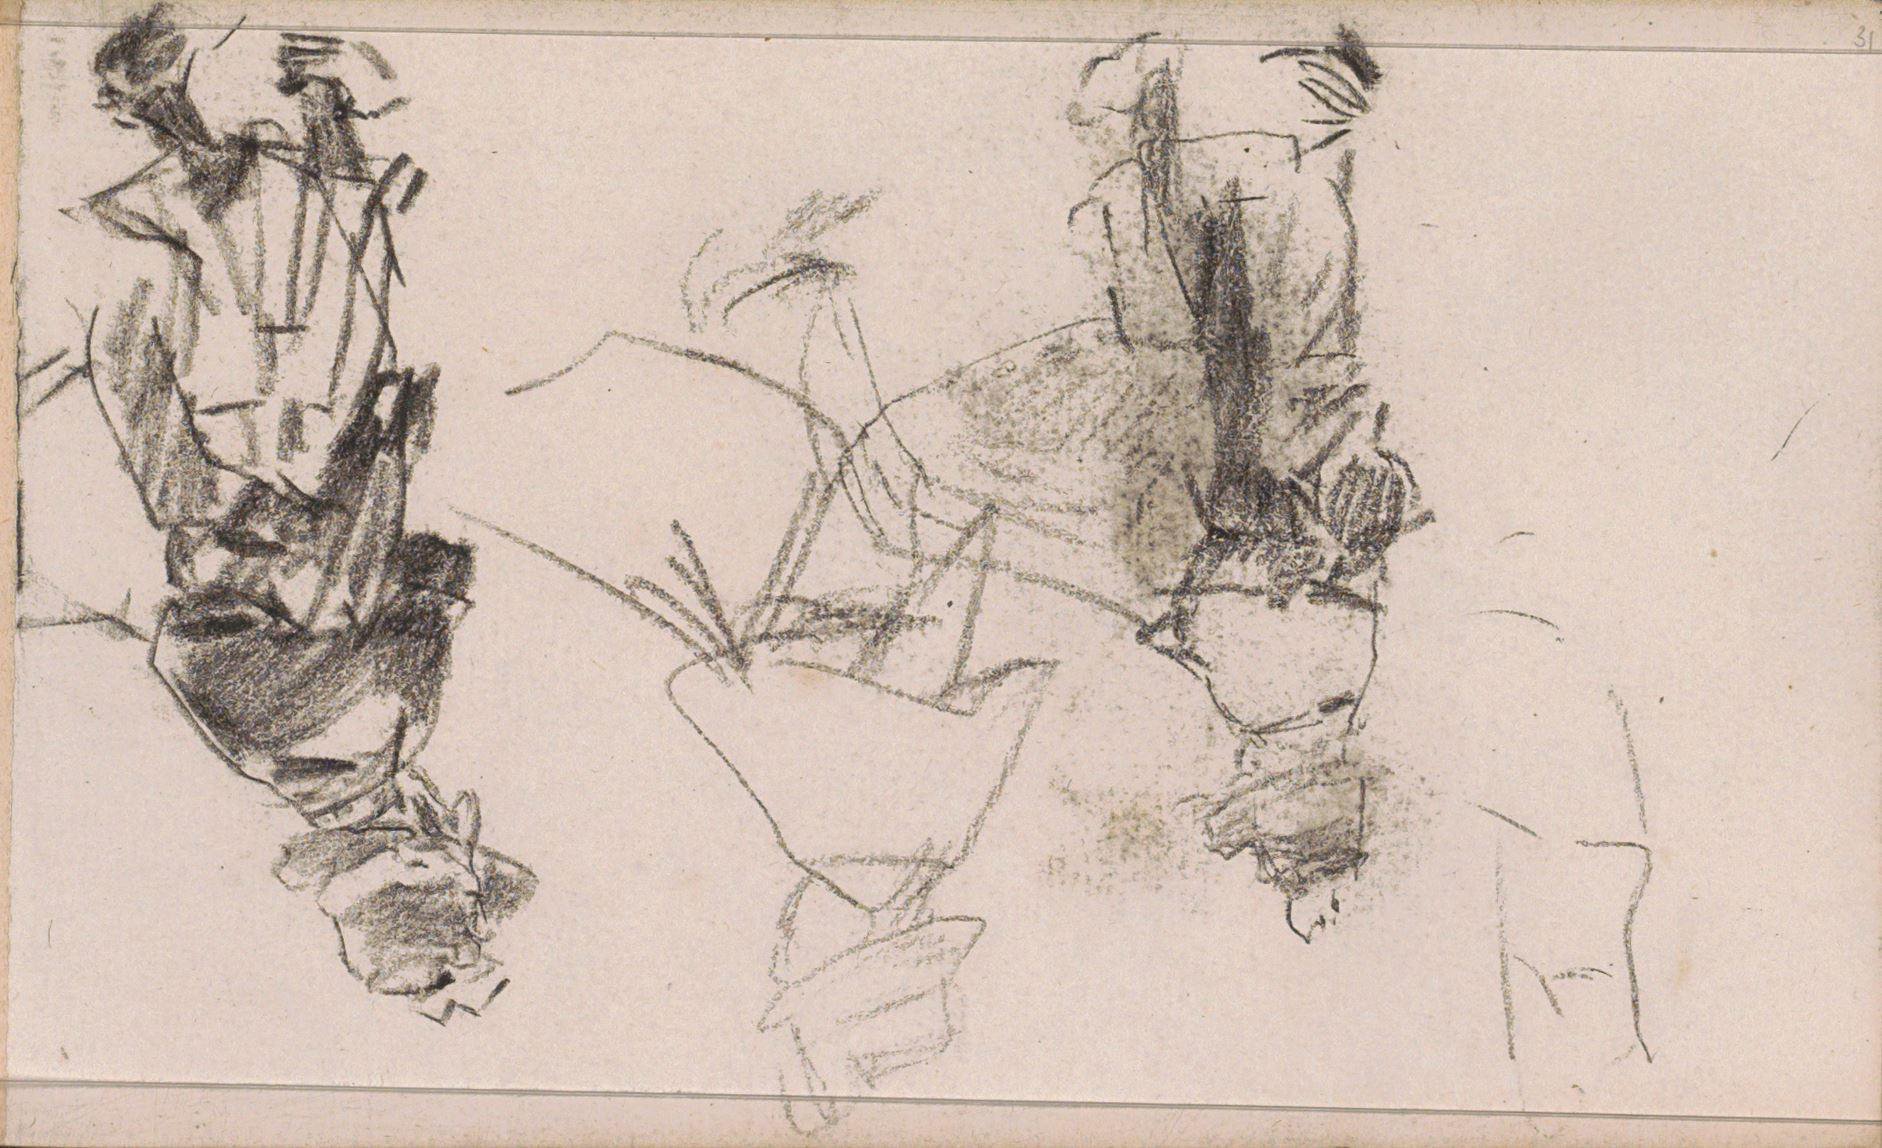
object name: sketchbook leaf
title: Studies van een meisje met hoed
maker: isaac israels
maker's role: draughtsman, painter, print maker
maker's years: 1865-1934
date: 1875-1934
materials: chalk, paper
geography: the hague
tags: girl (child between toddler and youth)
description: Ze houdt mogelijk een lijn vast. Pagina 31 uit schetsboek XLVIII met 62 pagina's.